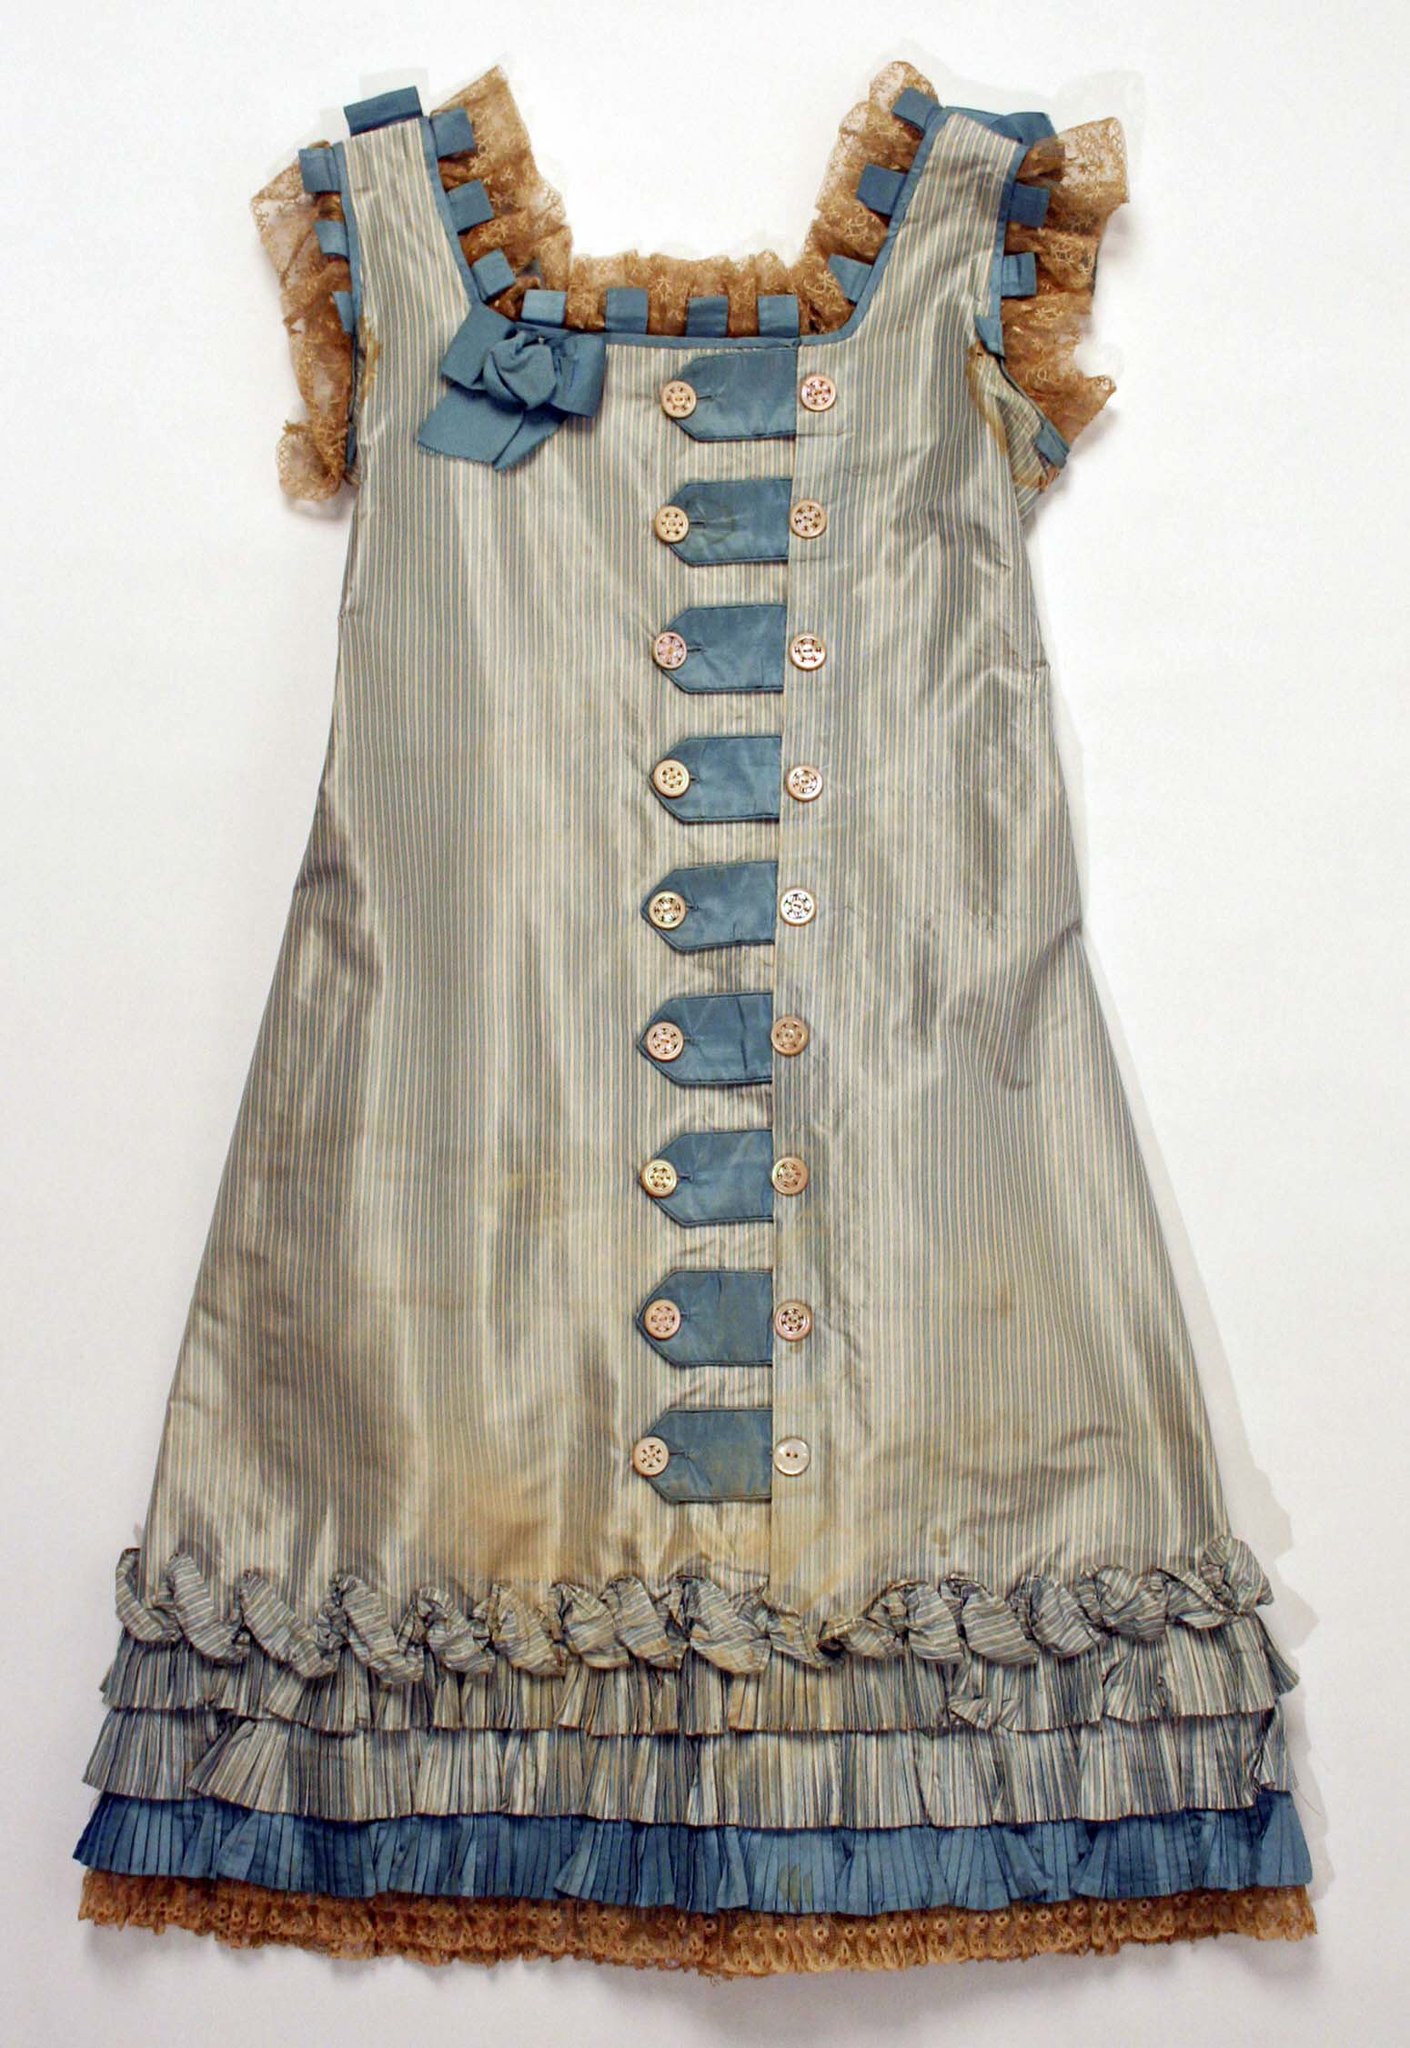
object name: dress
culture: american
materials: cotton, mother of pearl, silk